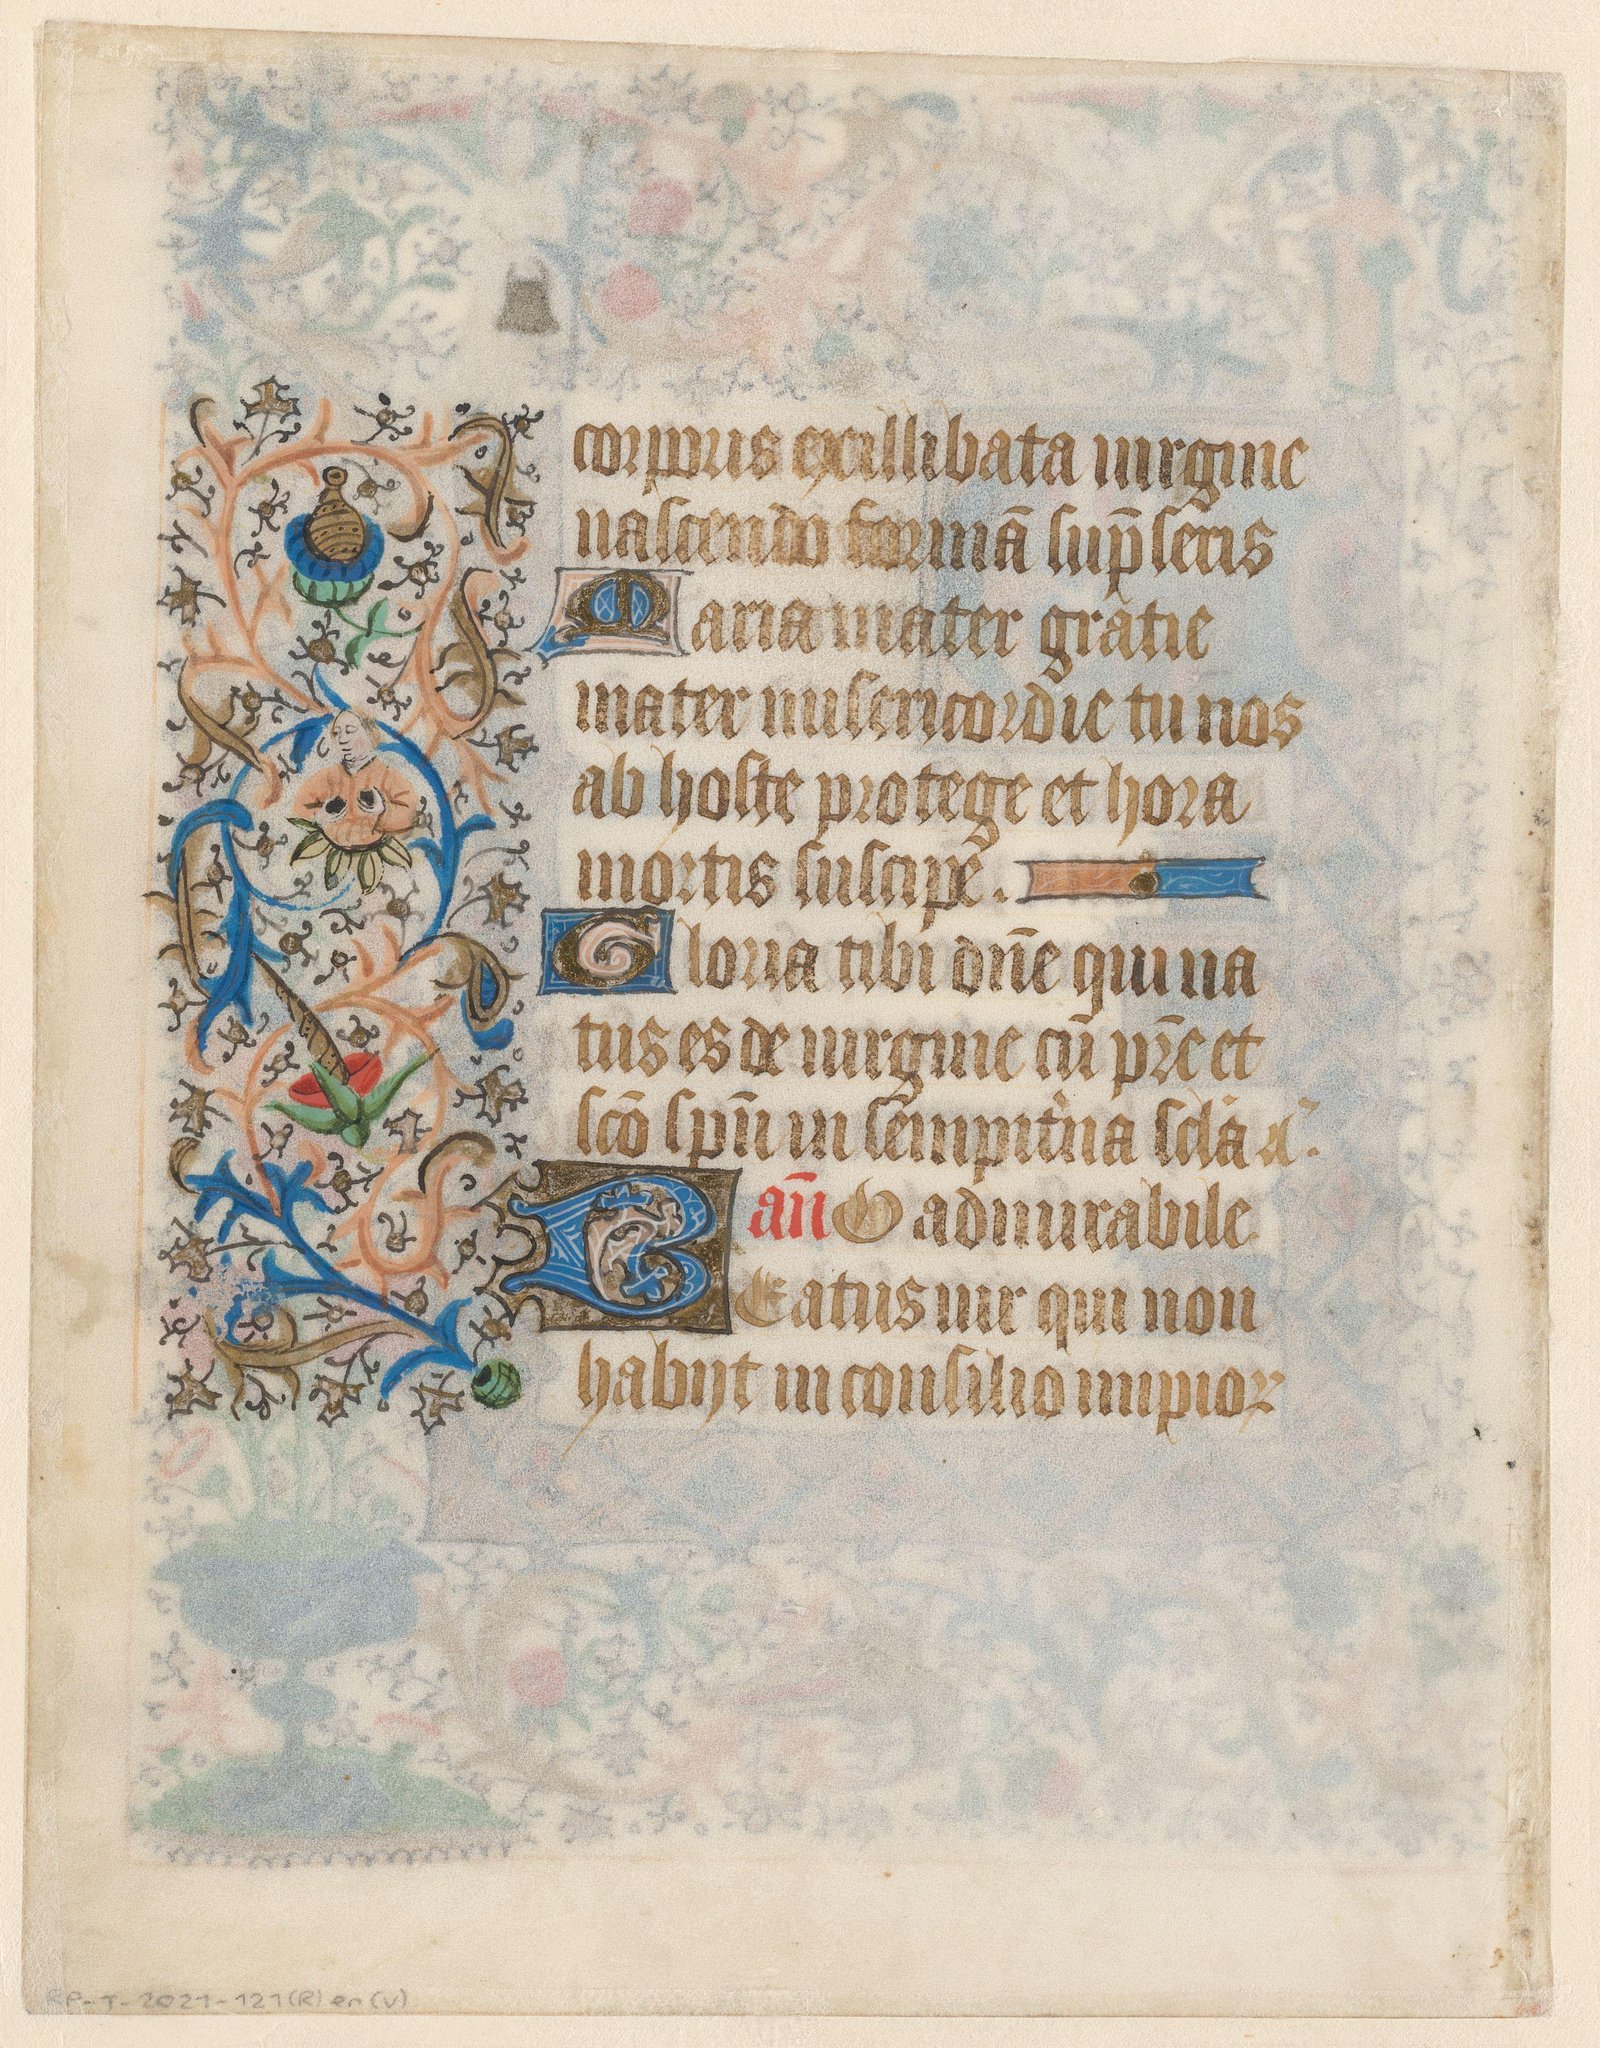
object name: drawing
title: Blad uit een getijdenboek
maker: Anonymous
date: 1400-1449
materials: paint, gold leaf, ink, parchment, watercolor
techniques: brush, pen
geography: france